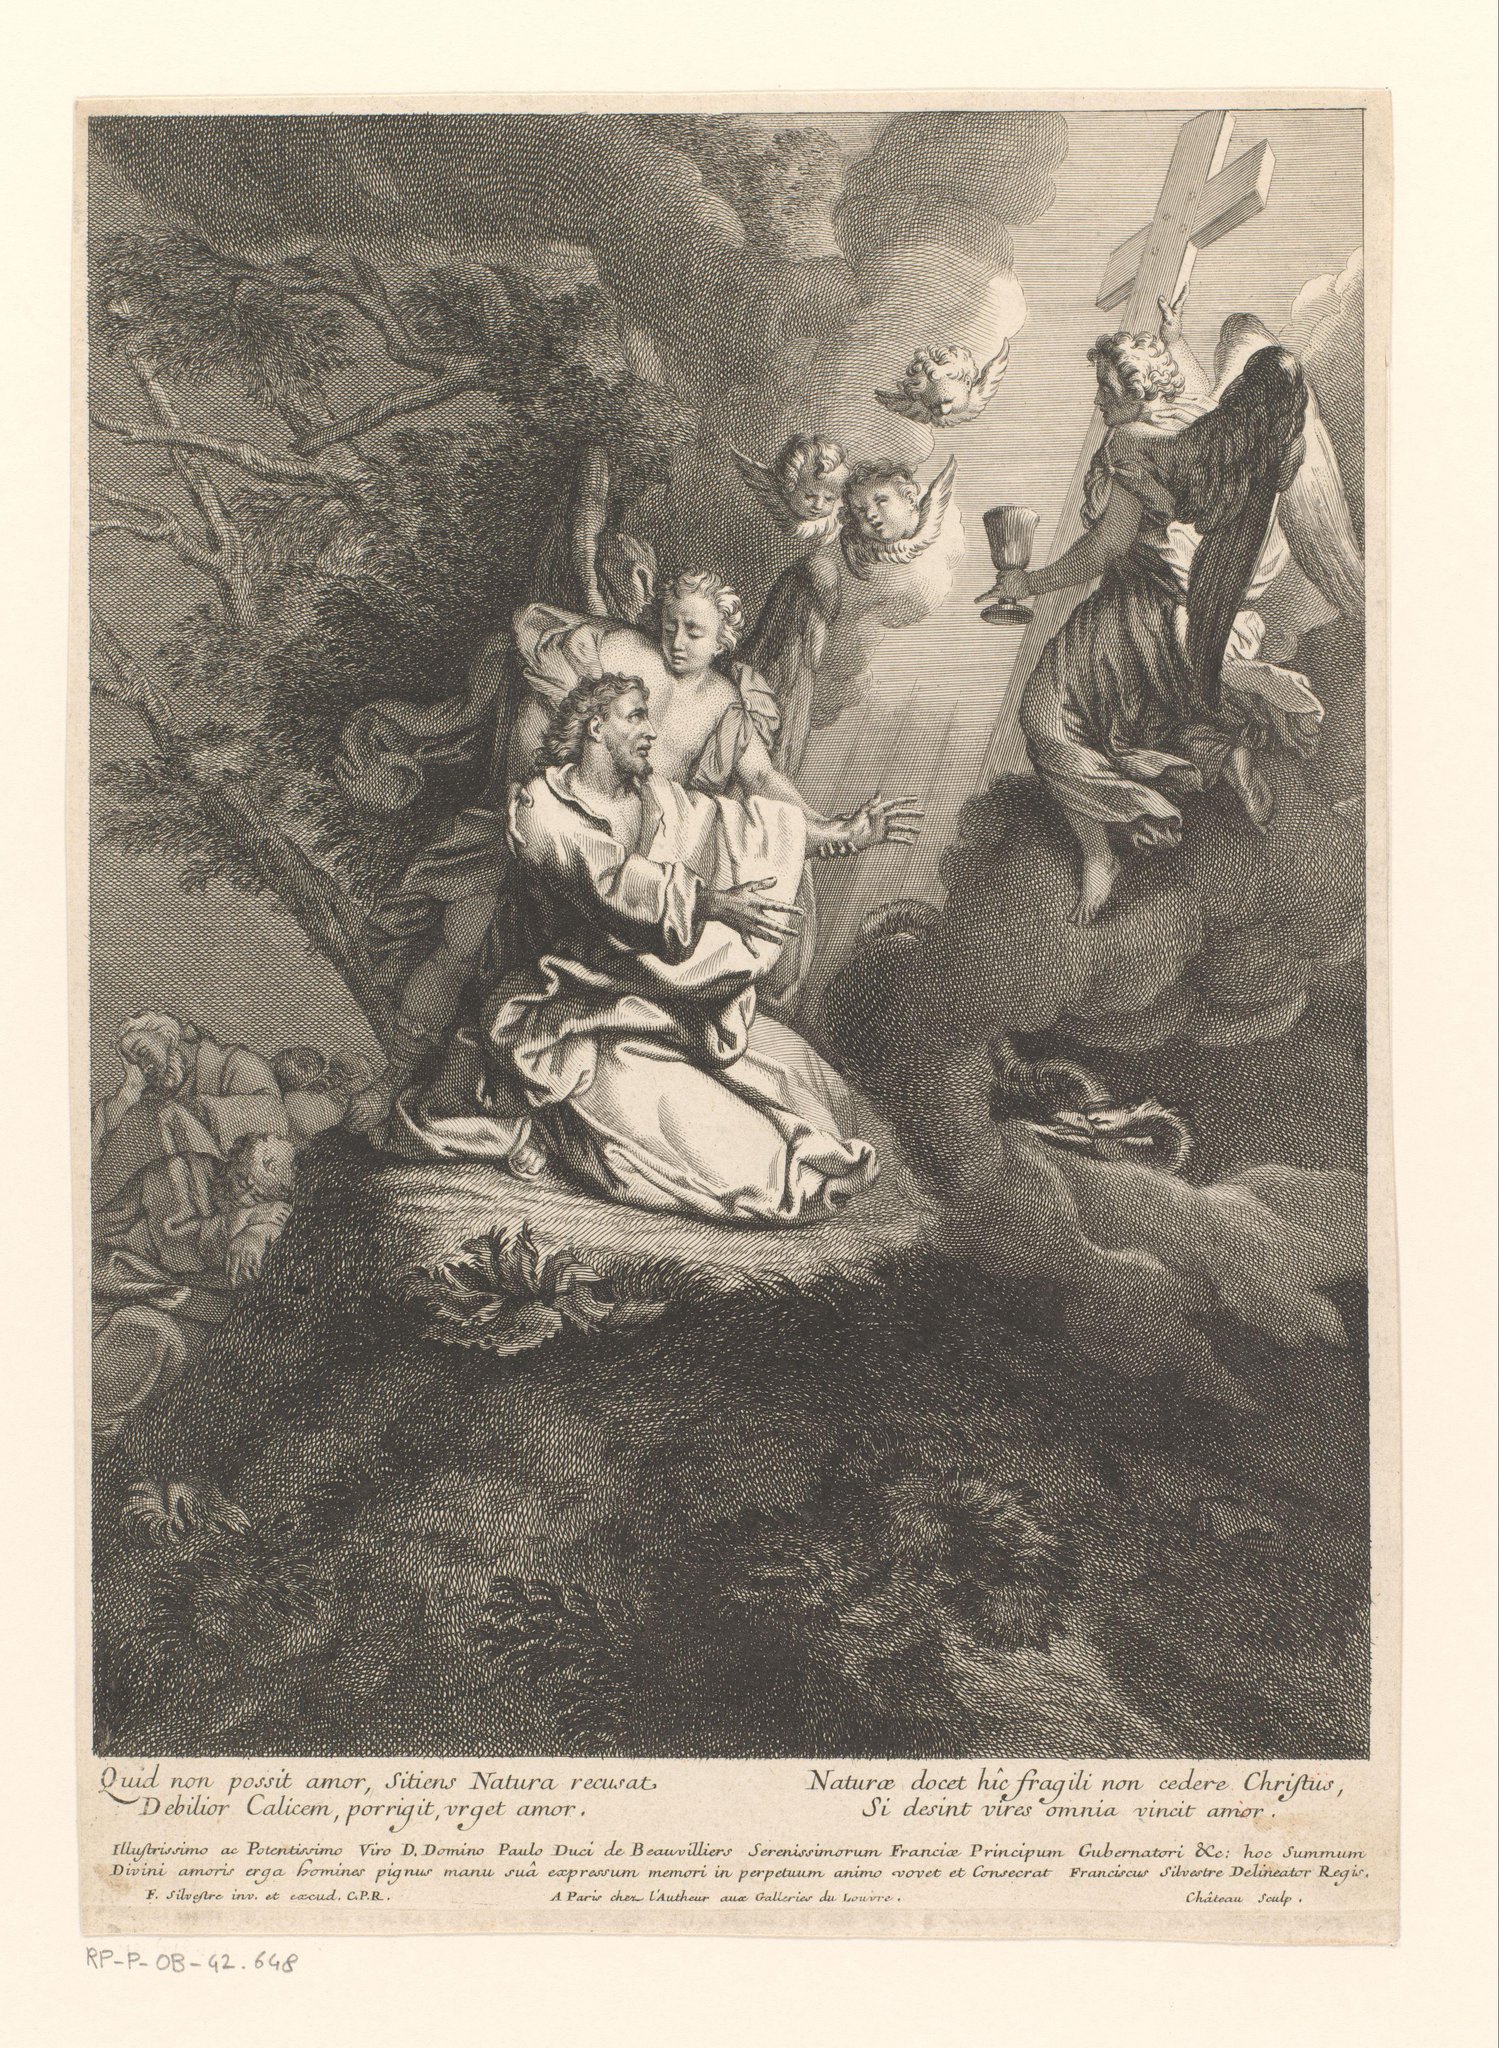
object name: print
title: Christus in de hof van Gethsemane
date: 1690-1738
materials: paper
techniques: engraving, etching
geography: france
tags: gethsemane, mount of olives, 'oelberg' (matthew 26:36-56; mark 14:32-52; luke 22:39-53; john 18:1-12), agony of christ: to comfort him one or more angels appear to christ with chalice and/or cross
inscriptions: collector's mark: Lugt 240